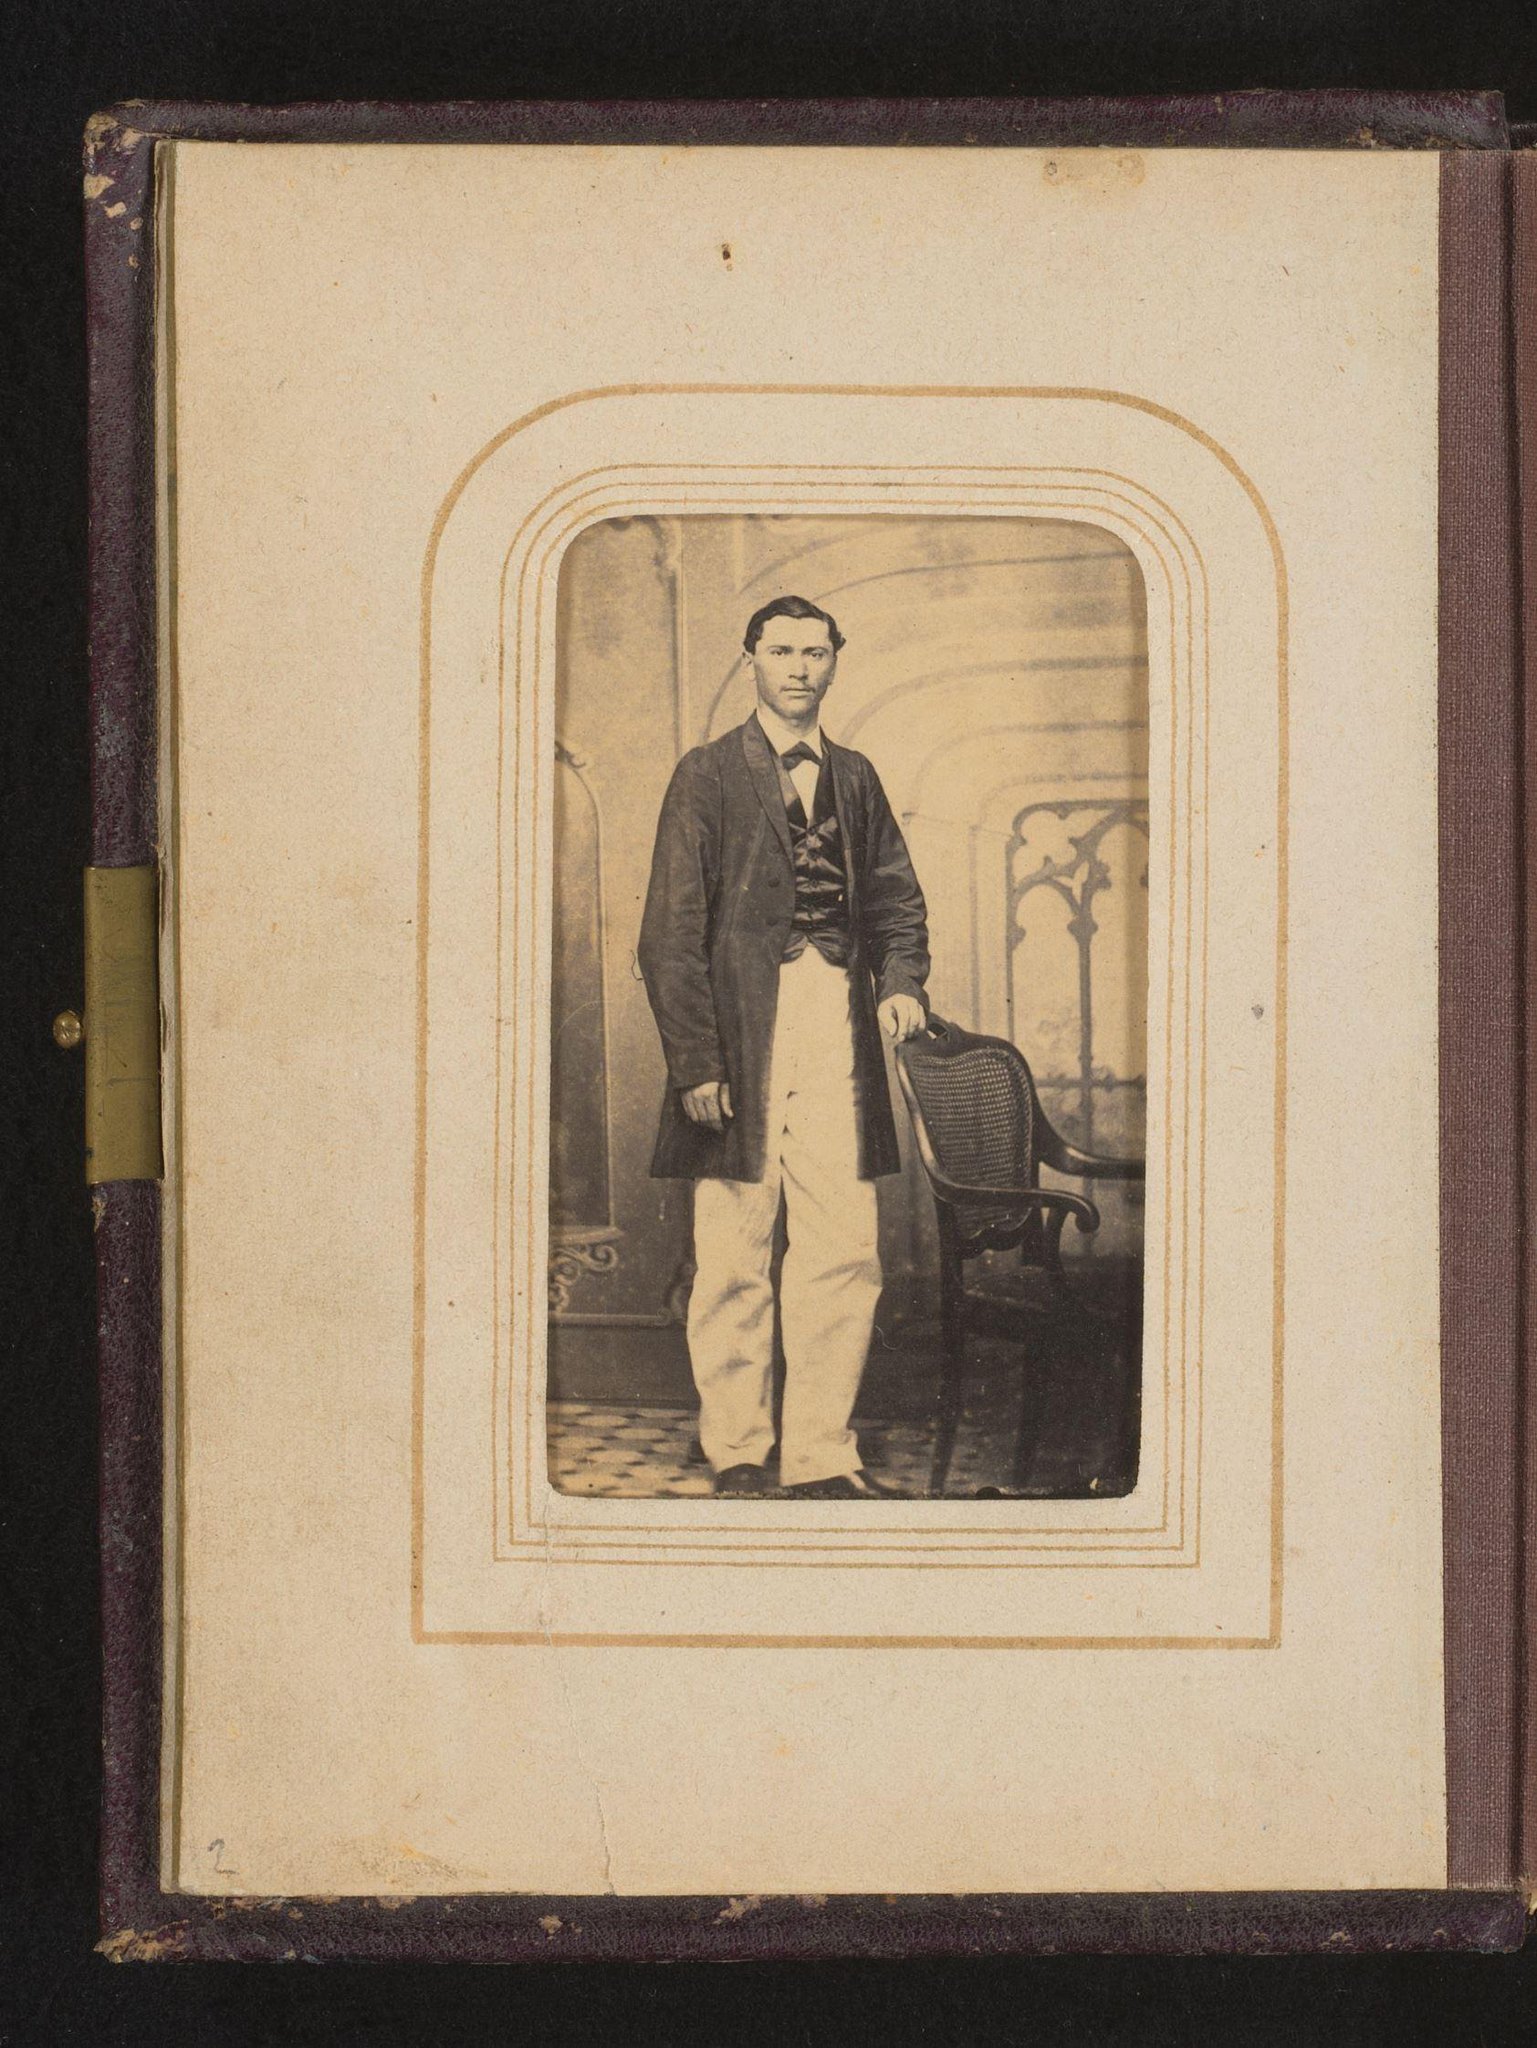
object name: photograph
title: Portret van een staande man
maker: Anonymous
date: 1860-1900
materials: cardboard, photographic support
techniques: albumen print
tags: historical persons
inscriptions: inscription: ‘[Molina/ Amistad 55]’